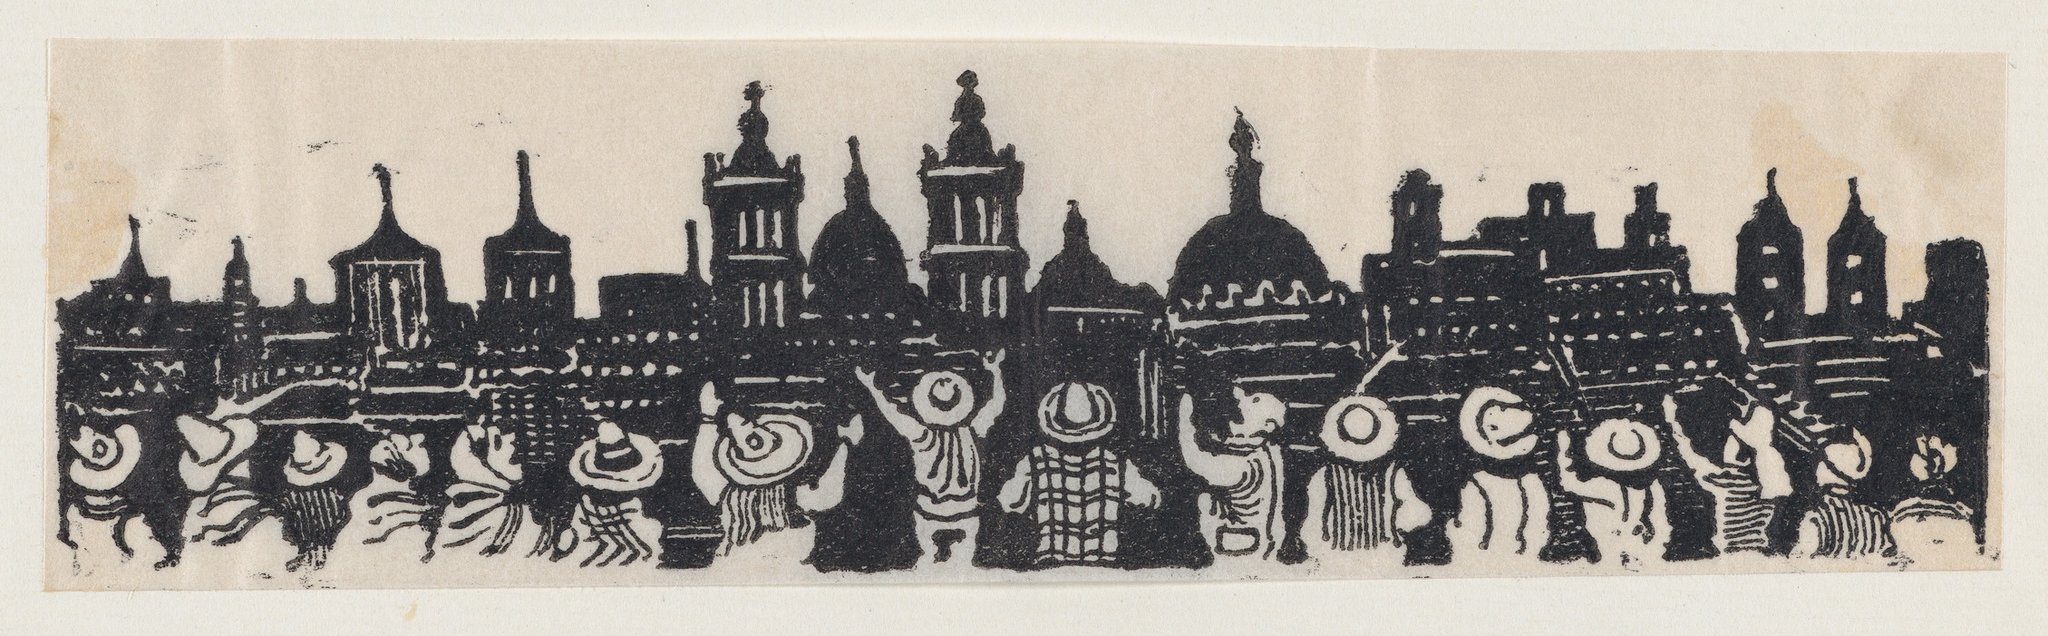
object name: print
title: A group of people looking at Mexico City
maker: josé guadalupe posada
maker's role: artist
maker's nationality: mexican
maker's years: 1852-1913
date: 1880-1910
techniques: lithography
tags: cities